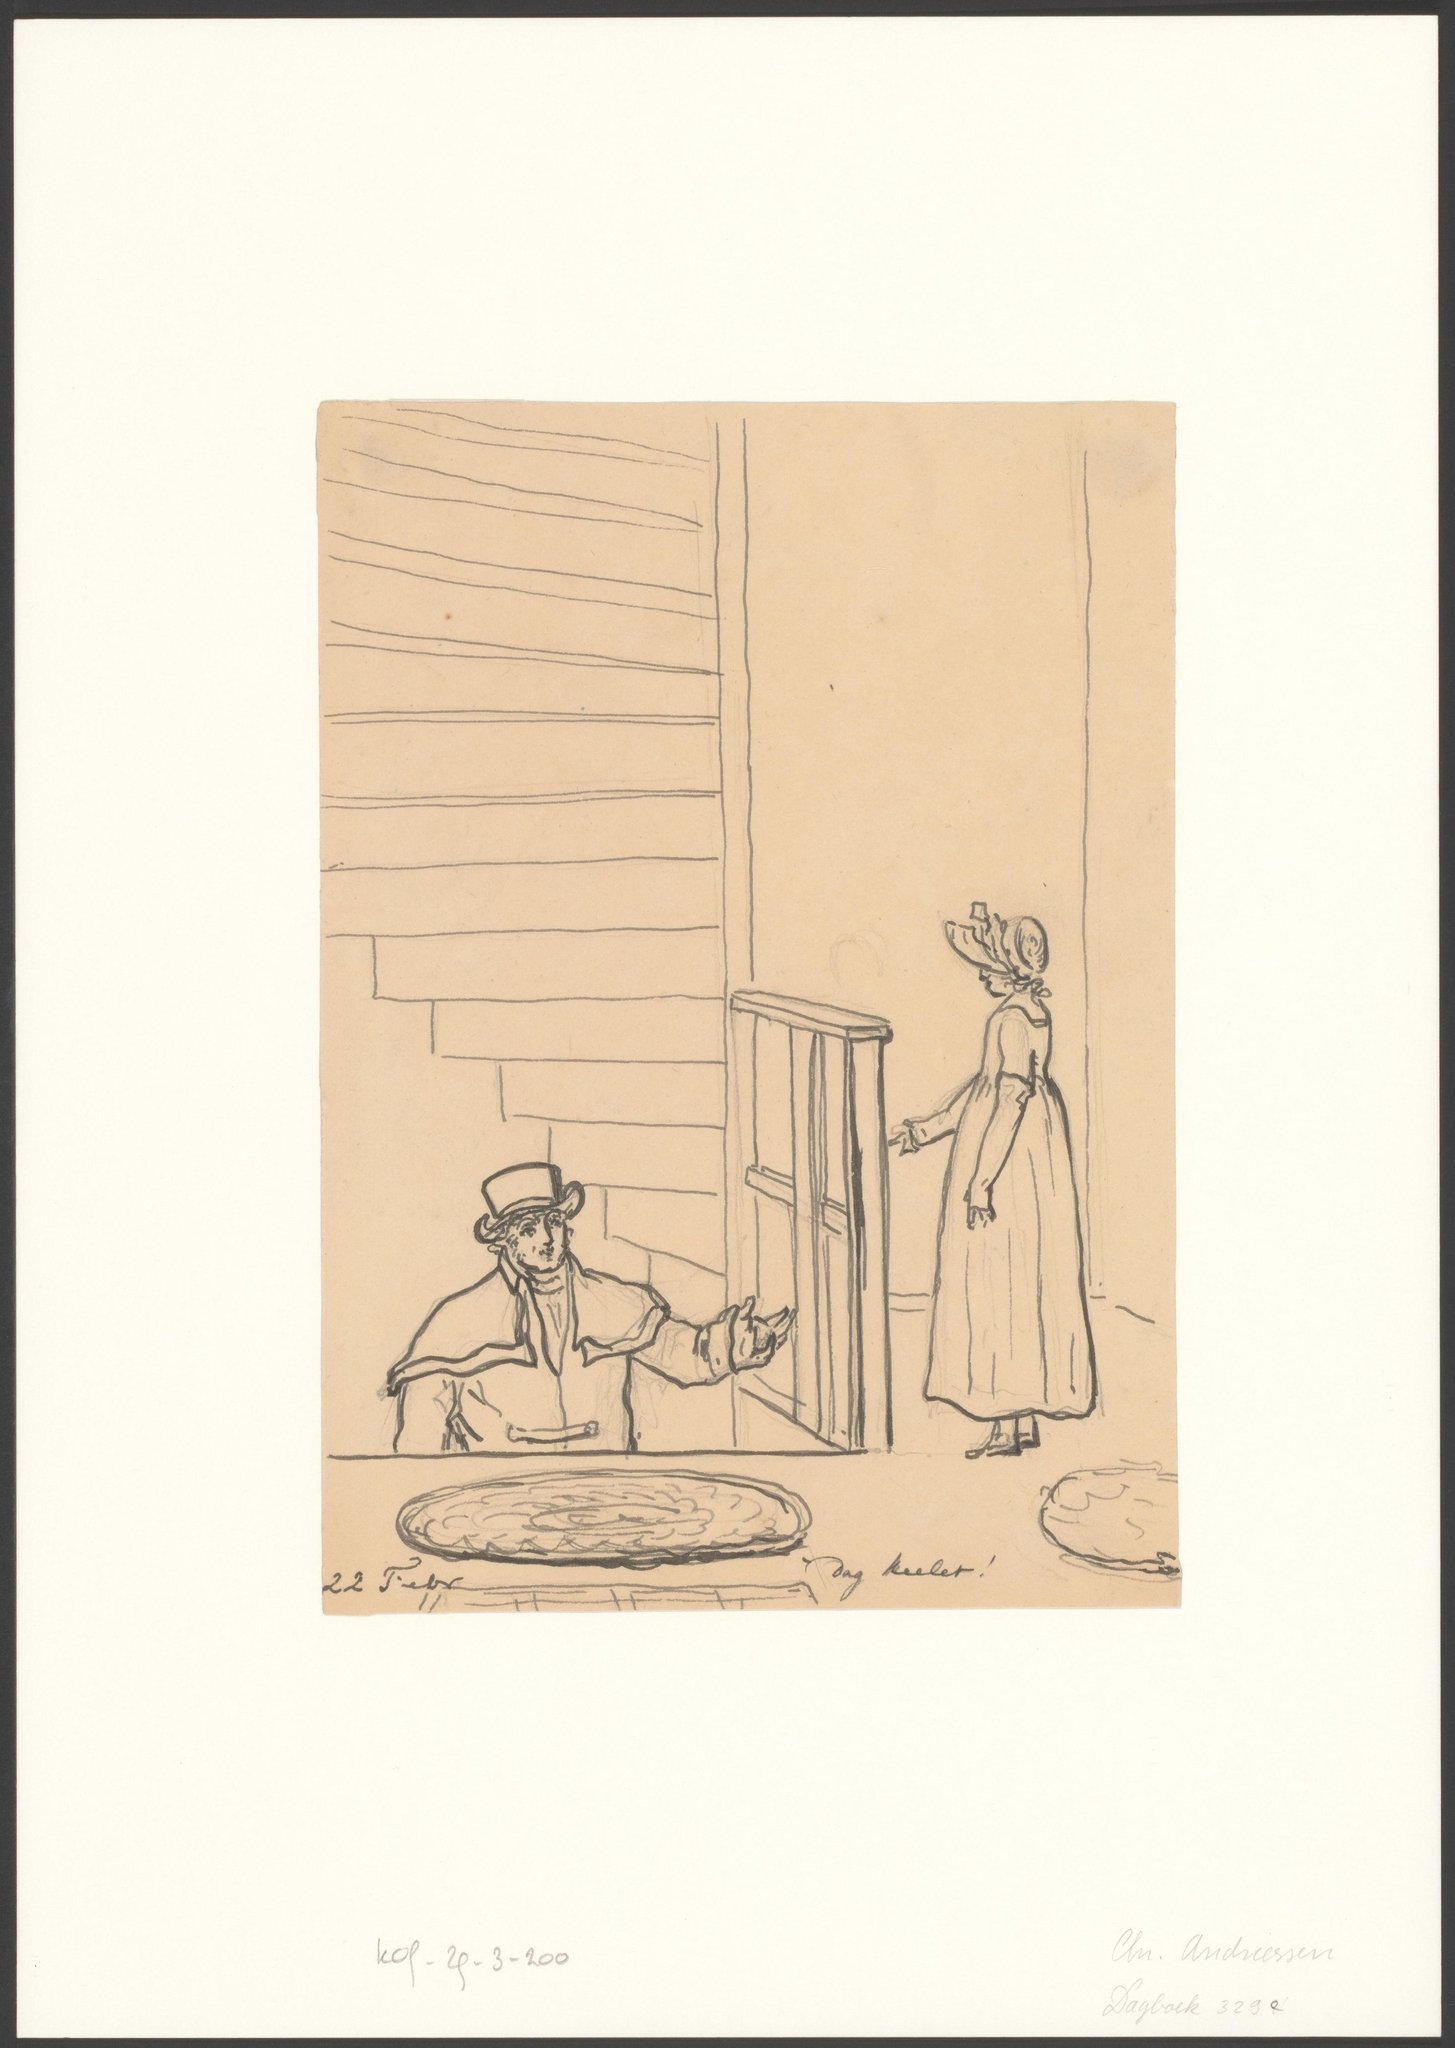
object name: drawing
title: Christiaan Andriessen wordt begroet door Cornelia Aletta van Hulst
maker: christiaan andriessen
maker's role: draughtsman, print maker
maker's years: 1775-1846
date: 1805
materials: ink, paper, pencil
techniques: pen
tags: amsterdam, print maker, draughtsman, christiaan andriessen, climbing, staircase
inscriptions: inscription: ‘22 Febr dag Keelet!’, signature: ‘J Andriessen’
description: Christiaan Andriessen komt op bezoek bij zijn zus en zwager in de Leidsestraat. Hij wordt boven aan de trap begroet door zijn nichtje, Cornelia Aletta van Hulst.